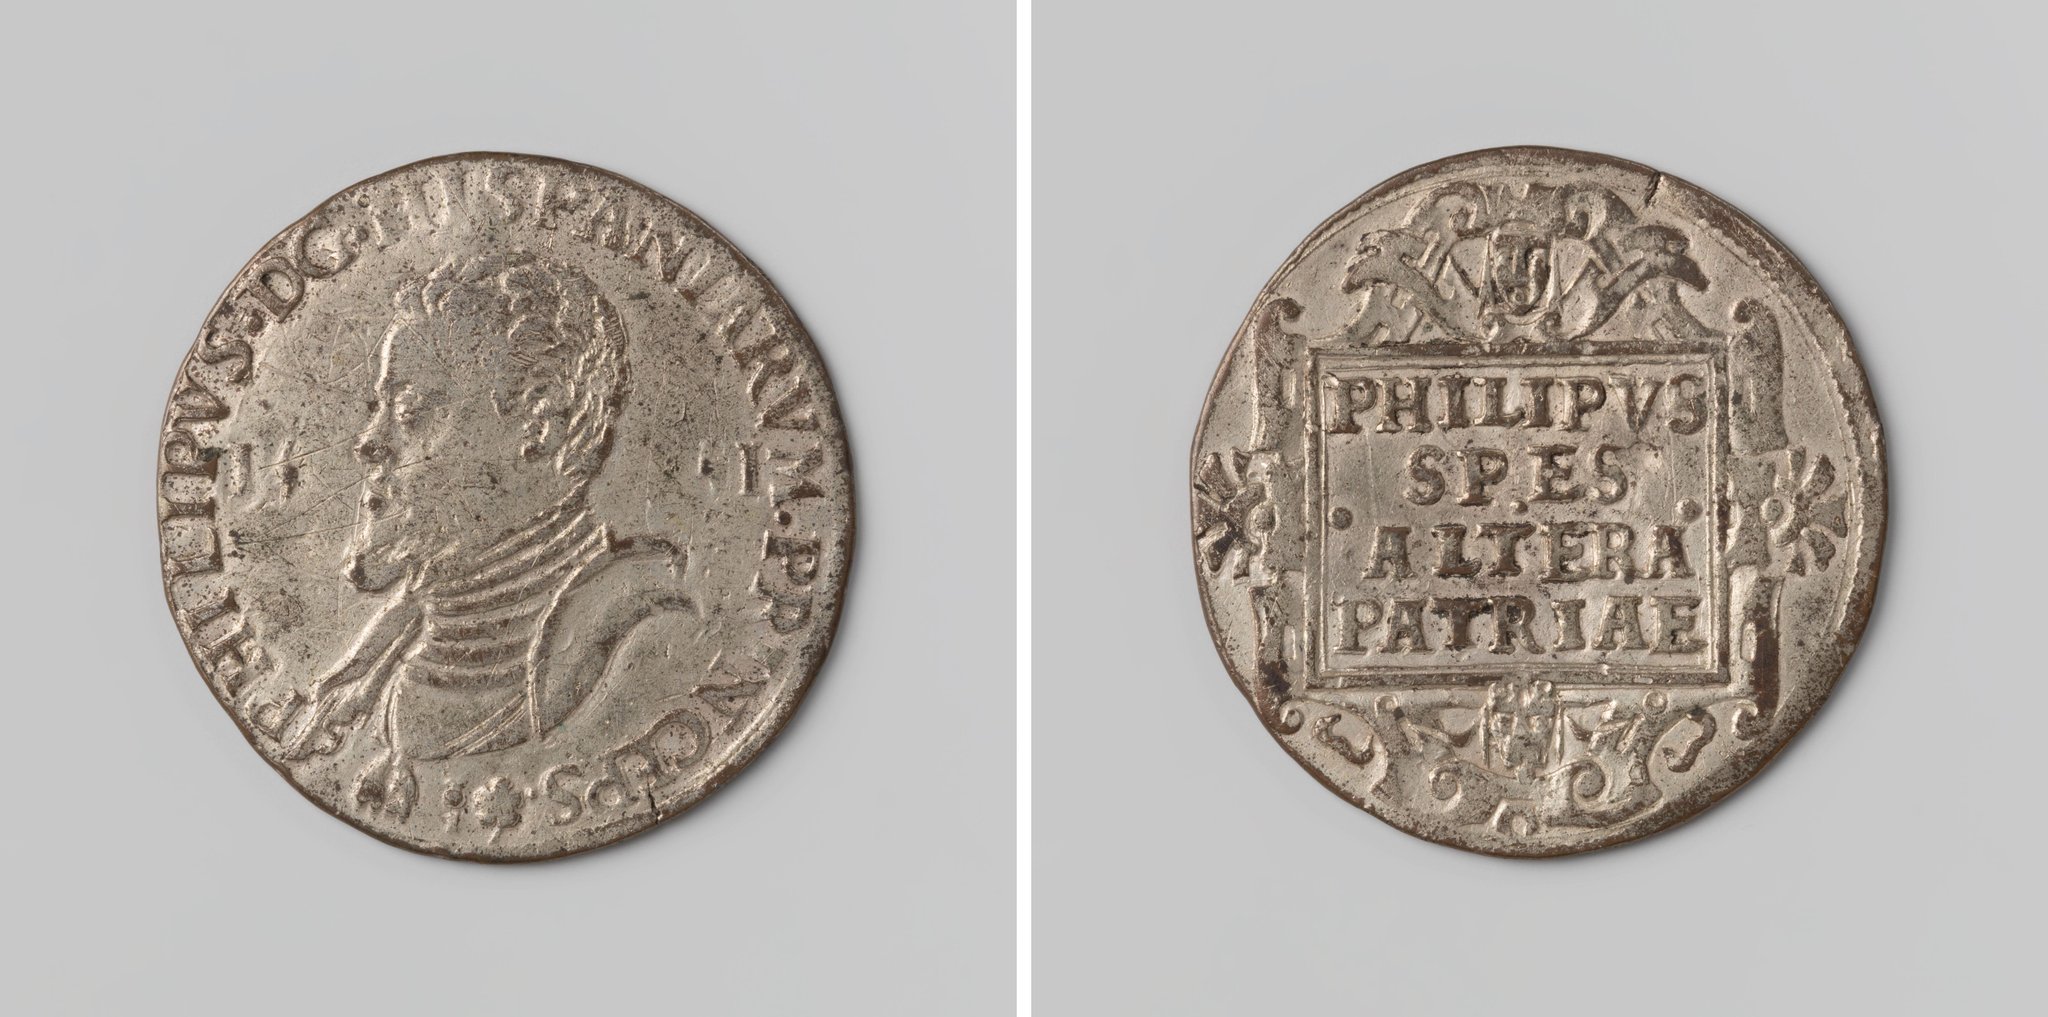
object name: jeton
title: Filips, erfprins van Spanje, opvolger van Karel V als heer der Nederlanden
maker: Anonymous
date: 1551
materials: metal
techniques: silvering, striking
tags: philip ii of spain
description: Voorzijde: borststuk man tussen jaartal binnen omschrift. Keerzijde: opschrift binnen versierd cartouche